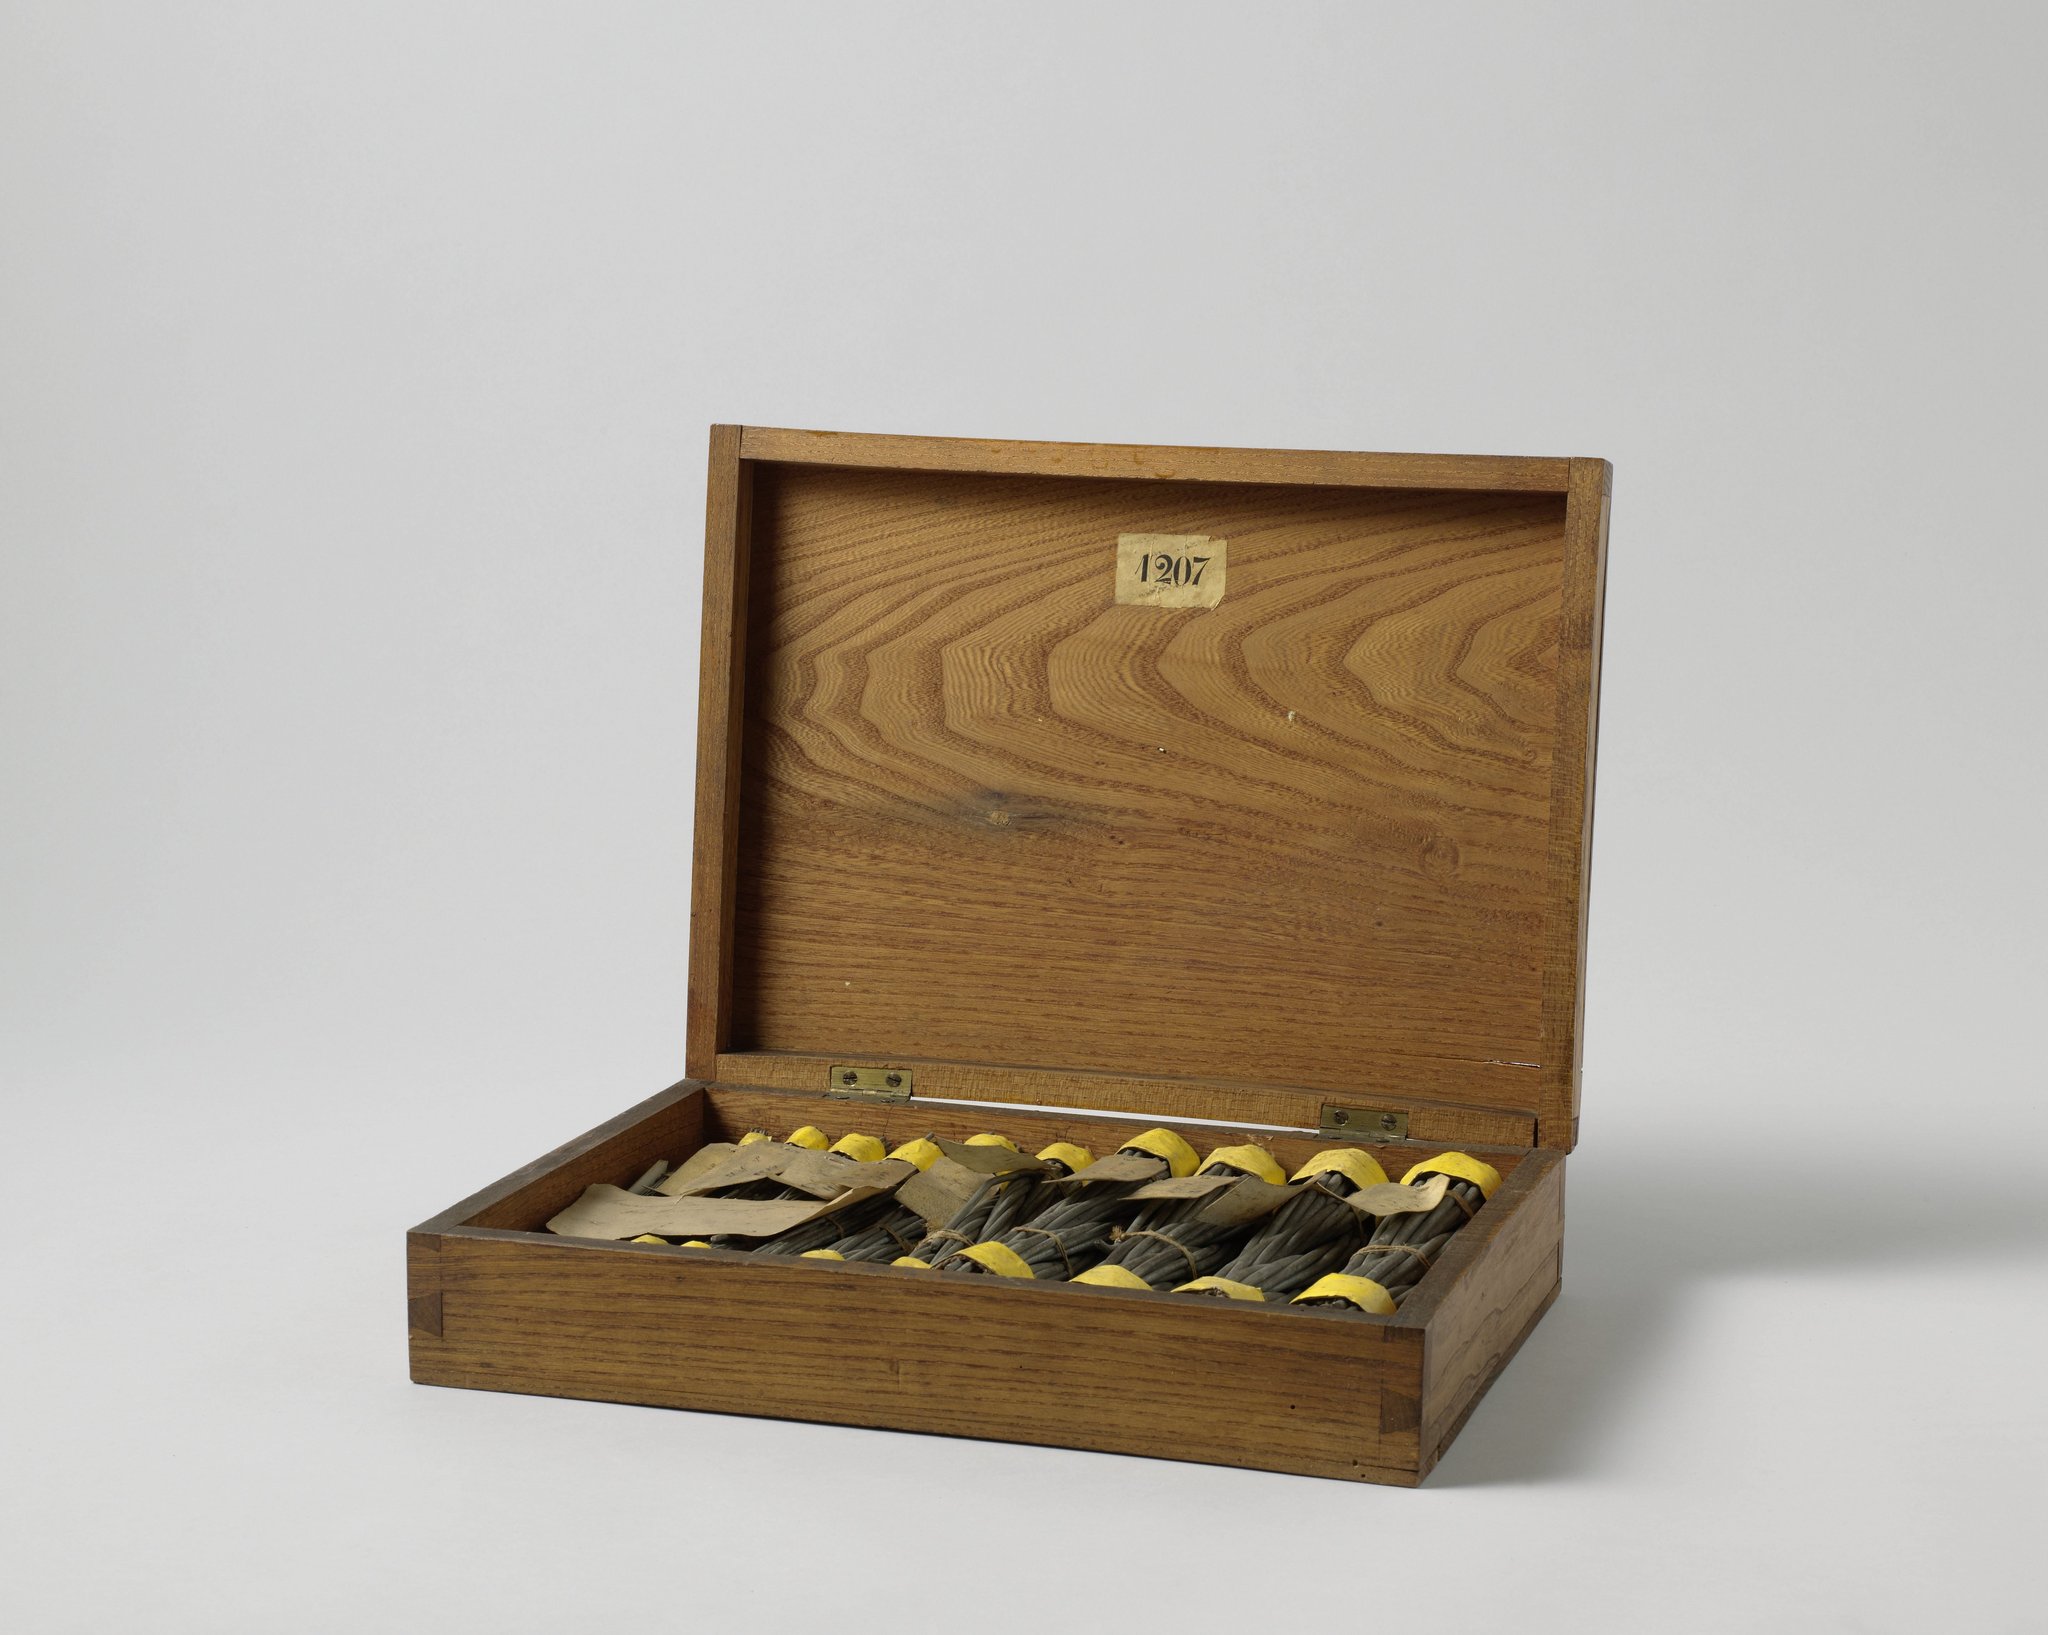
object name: sample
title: Box with Samples of Metal Shrouds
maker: Anonymous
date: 1866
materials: brass, iron, paper, parchment, fiber, wood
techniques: galvanization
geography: netherlands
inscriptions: inscription, on a separate note: ‘Verschillende soorten van ijzerdraadtouw / tot staand want.’, inscription, on the parchment labels: ‘0,135 / dr Nº 6 // 0,122 // dr Nº 7 // 0,112 / dr Nº 8 // 0,102 / dr Nº 9 // 0,093 / dr Nº 10 // 0,084 / dr Nº 11 // 0,067 / dr Nº 13 // 0,060 / dr Nº 14 // 0.053 / dr Nº 15 // 0.039 / dr Nº 17 // 0,027 / dr Nº 19 - 20. / doen vervallen’, label, on the inside of the box: ‘1207’ former inventory label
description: Kistje met elf monsters van ijzerdraad voor staand-want, alle wantslag met zes kabelslag strengen om een zevende, alle strengen en het hart bestaande uit zeven garens. Ze zijn ieder samengebonden met touw en geel papier aan de uiteinden en dragen allemaal een perkamenten etiket met opschrift en een monster van het garen waaruit ze zijn samengesteld. Het etiket bij het kleinste monster draagt ook de instructie om het te doen vervallen.